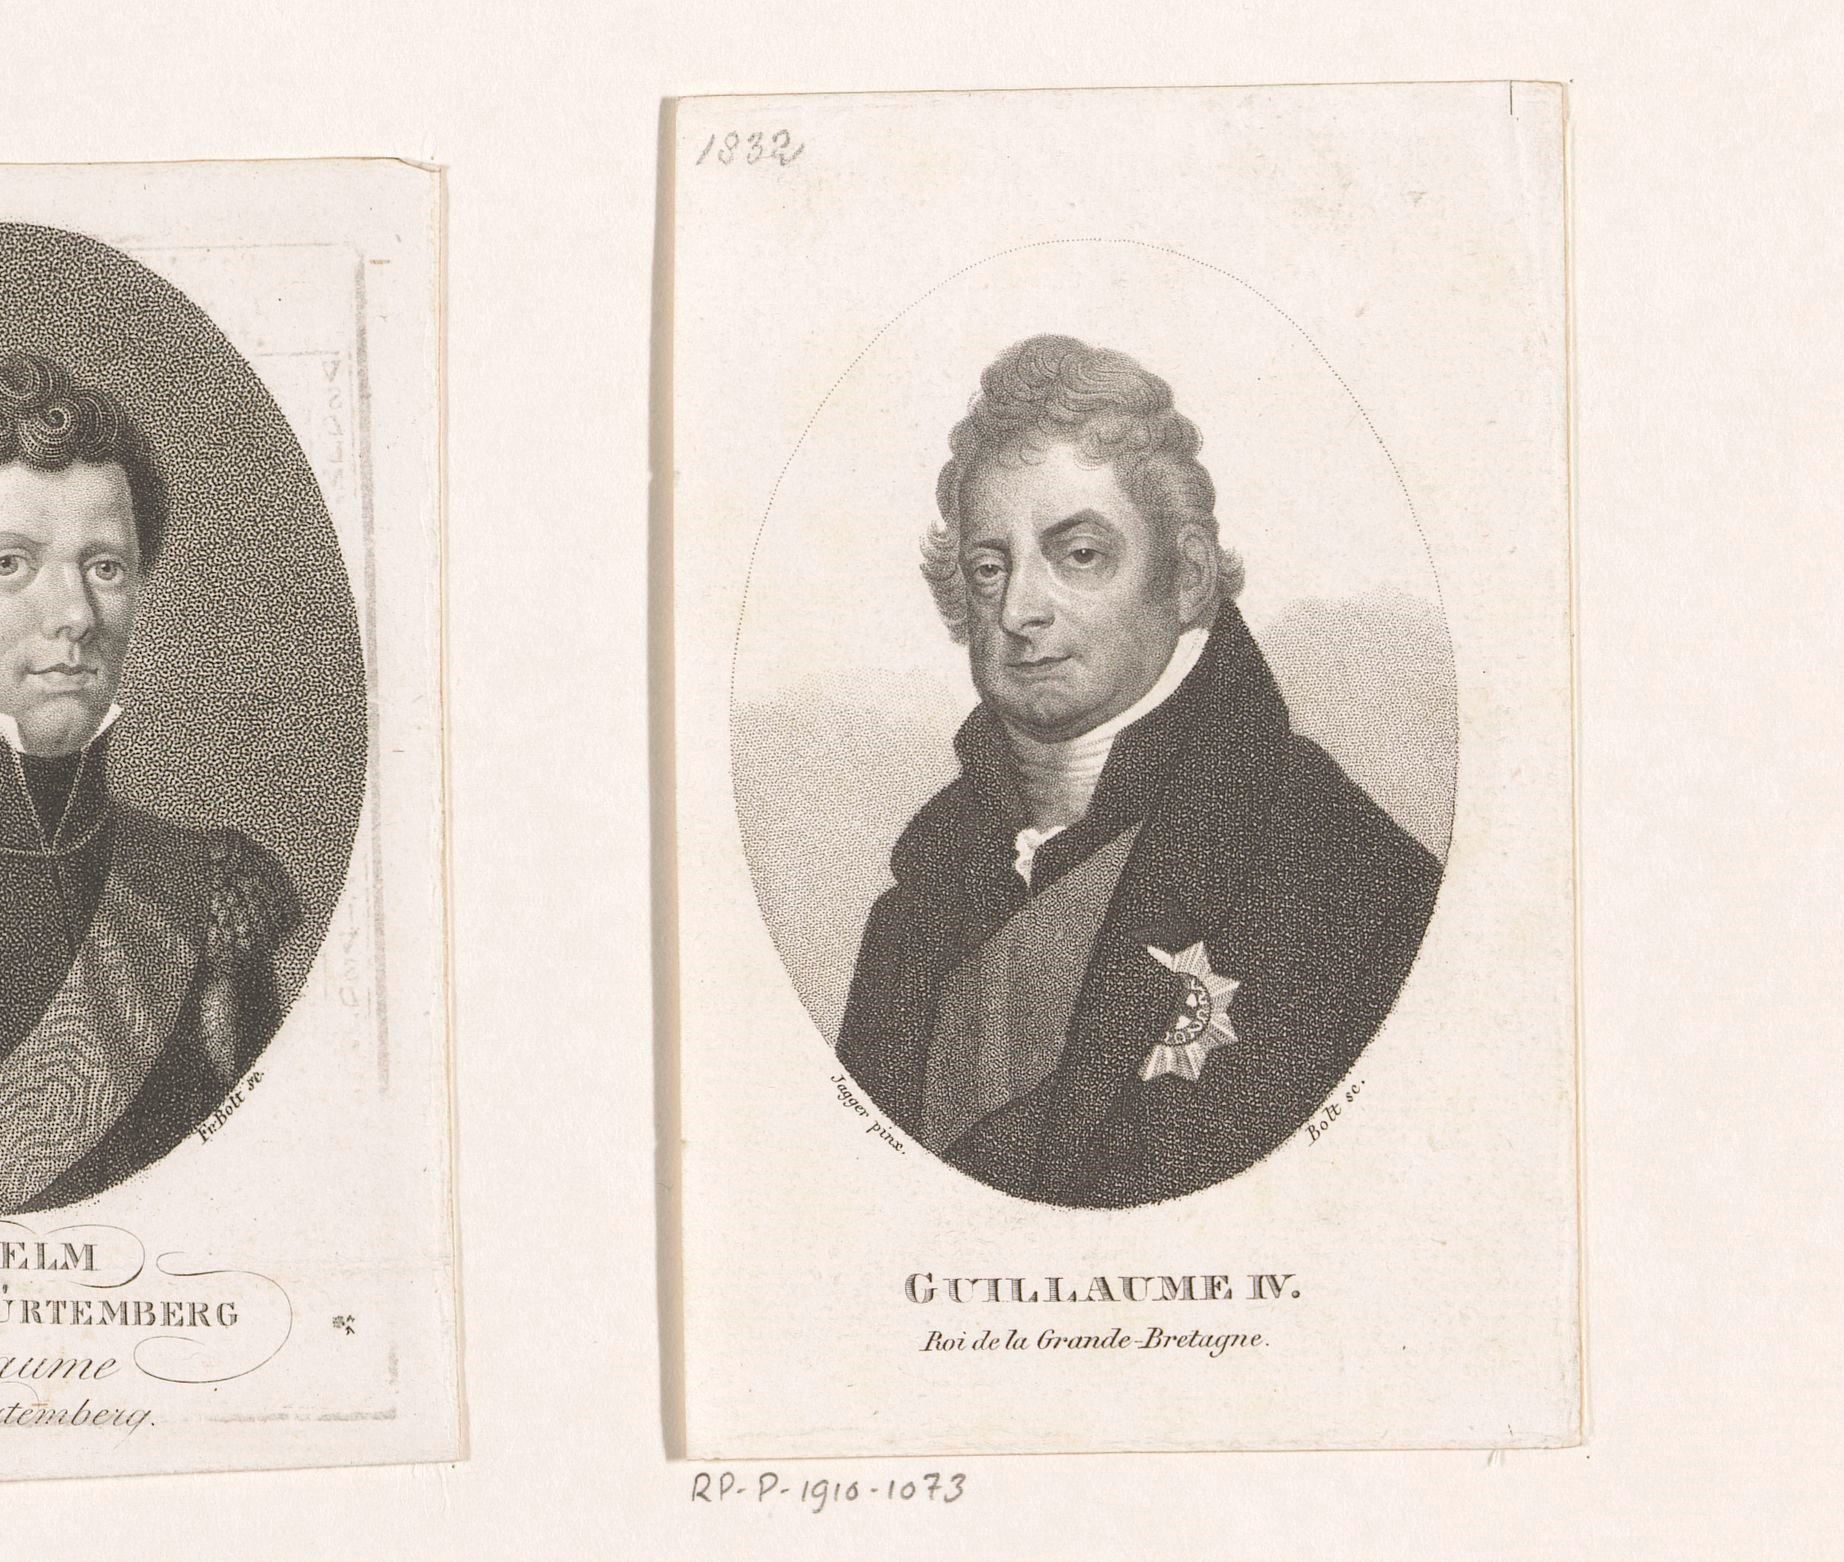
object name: book illustration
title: Portret van Willem IV Hendrik, koning van Groot-Brittannië en Hannover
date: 1832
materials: paper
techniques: stippling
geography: berlin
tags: london, willem iv hendrik (koning van het verenigd koninkrijk en hannover), knighthood order (garter) - insignia of a knighthood order, e.g.: badge, chain, historical persons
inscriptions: collector's mark: Lugt 2228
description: Prent afkomstig uit: Almanach de Gotha, 1832.